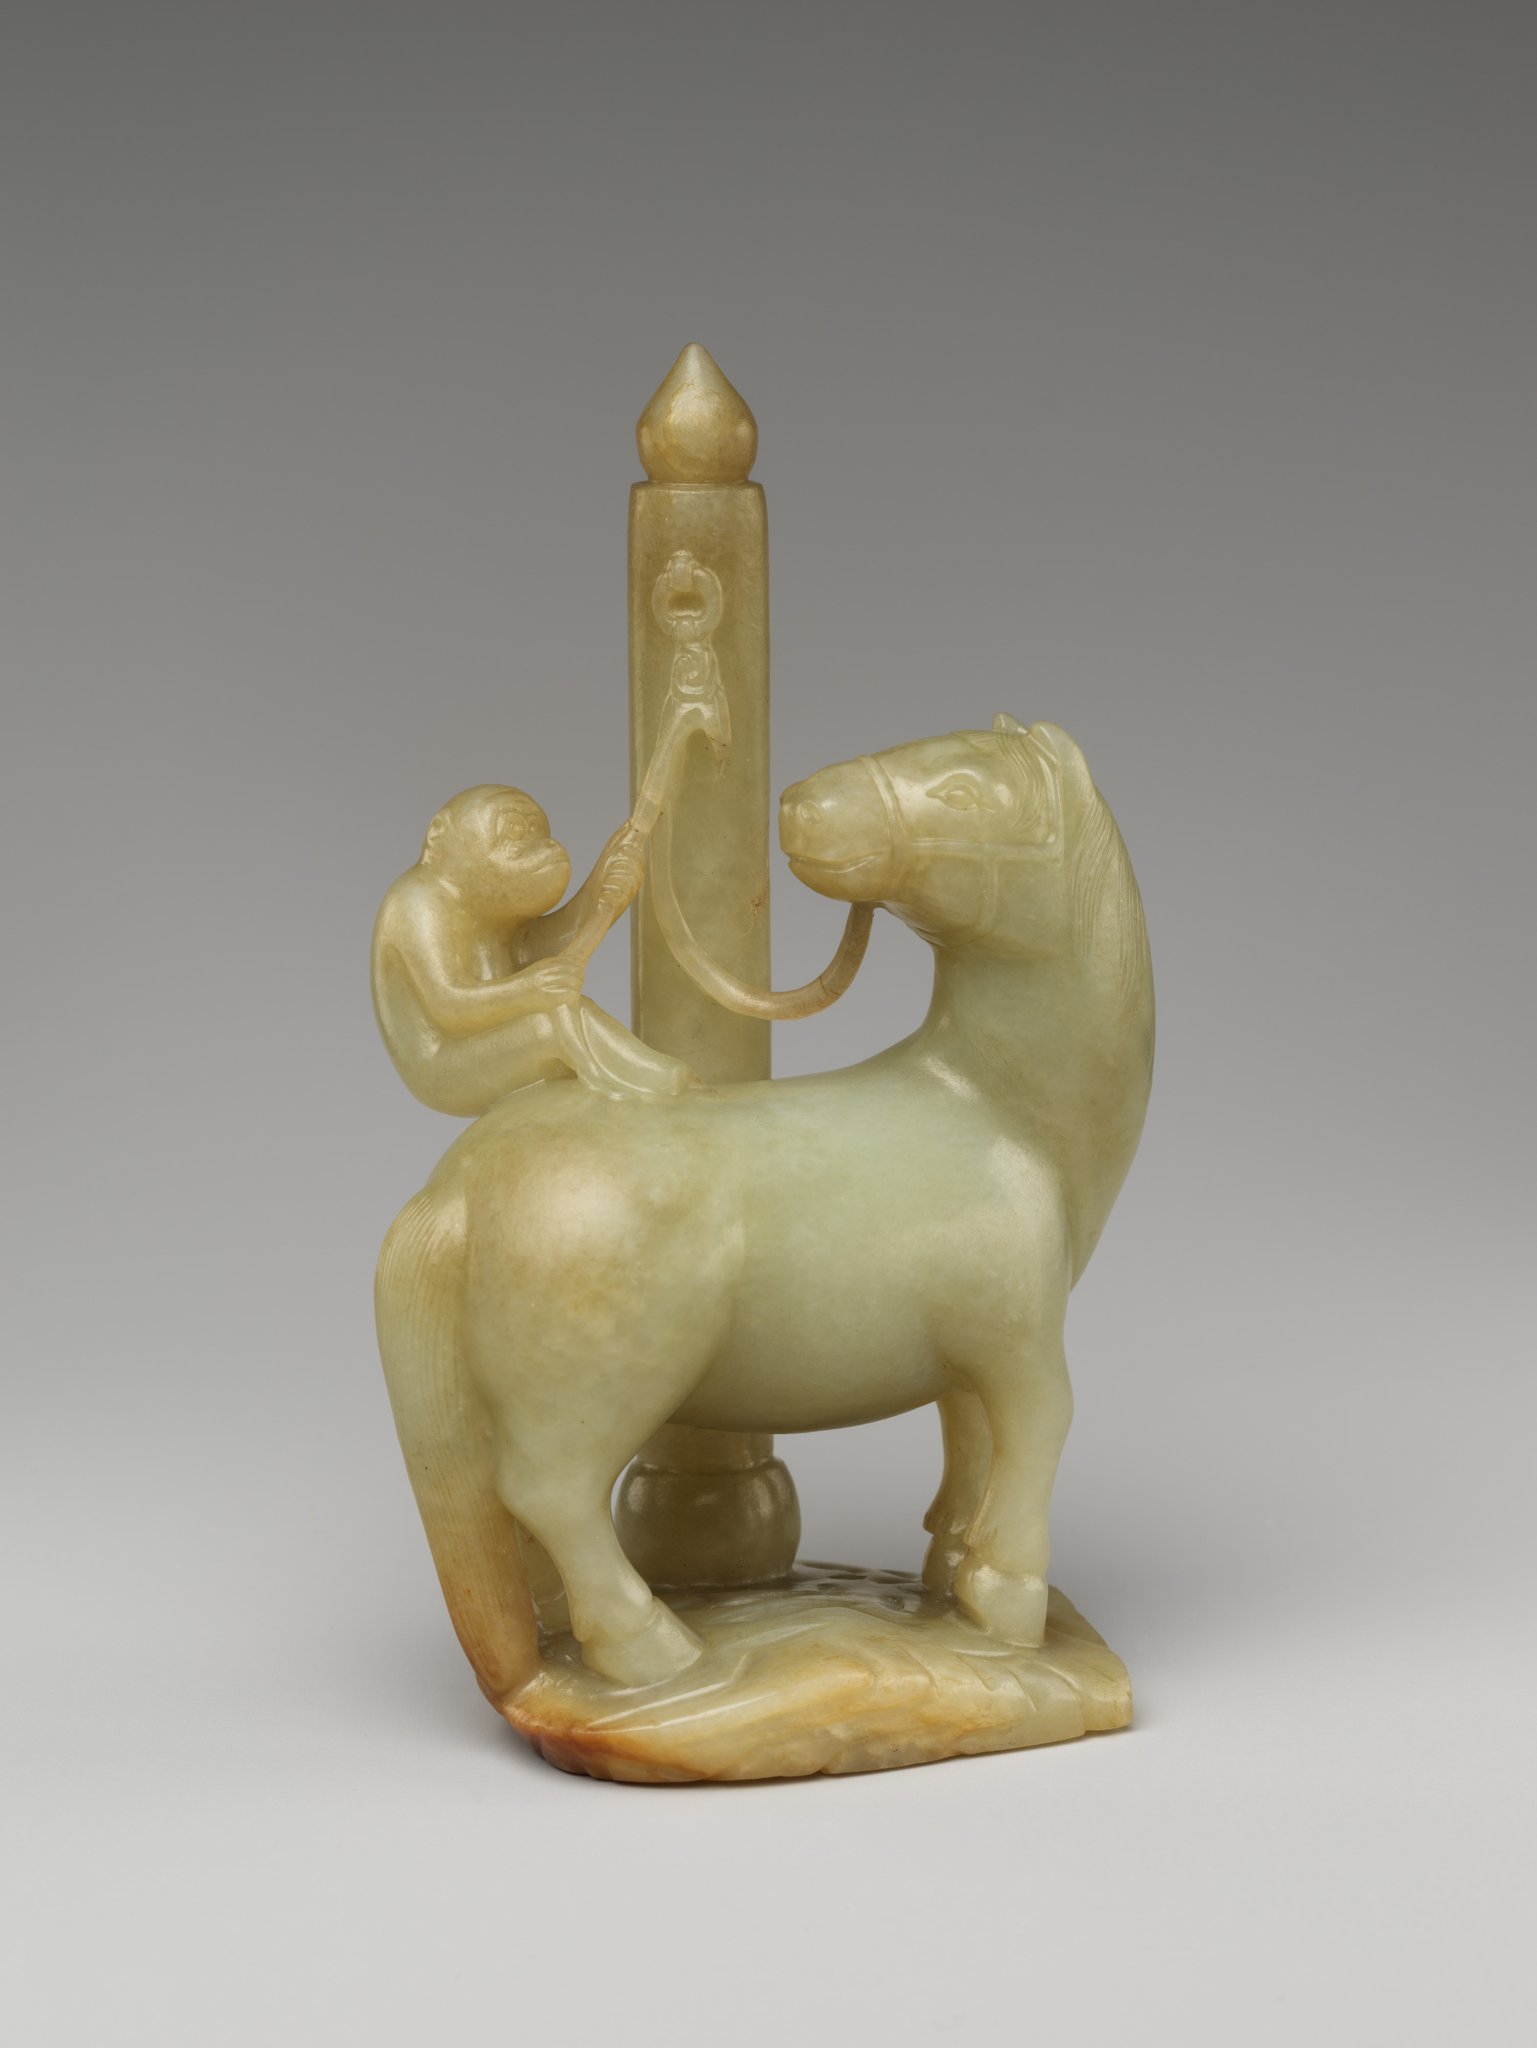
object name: figure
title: Horse and monkey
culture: chinese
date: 1601-1700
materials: jade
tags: horses,monkeys